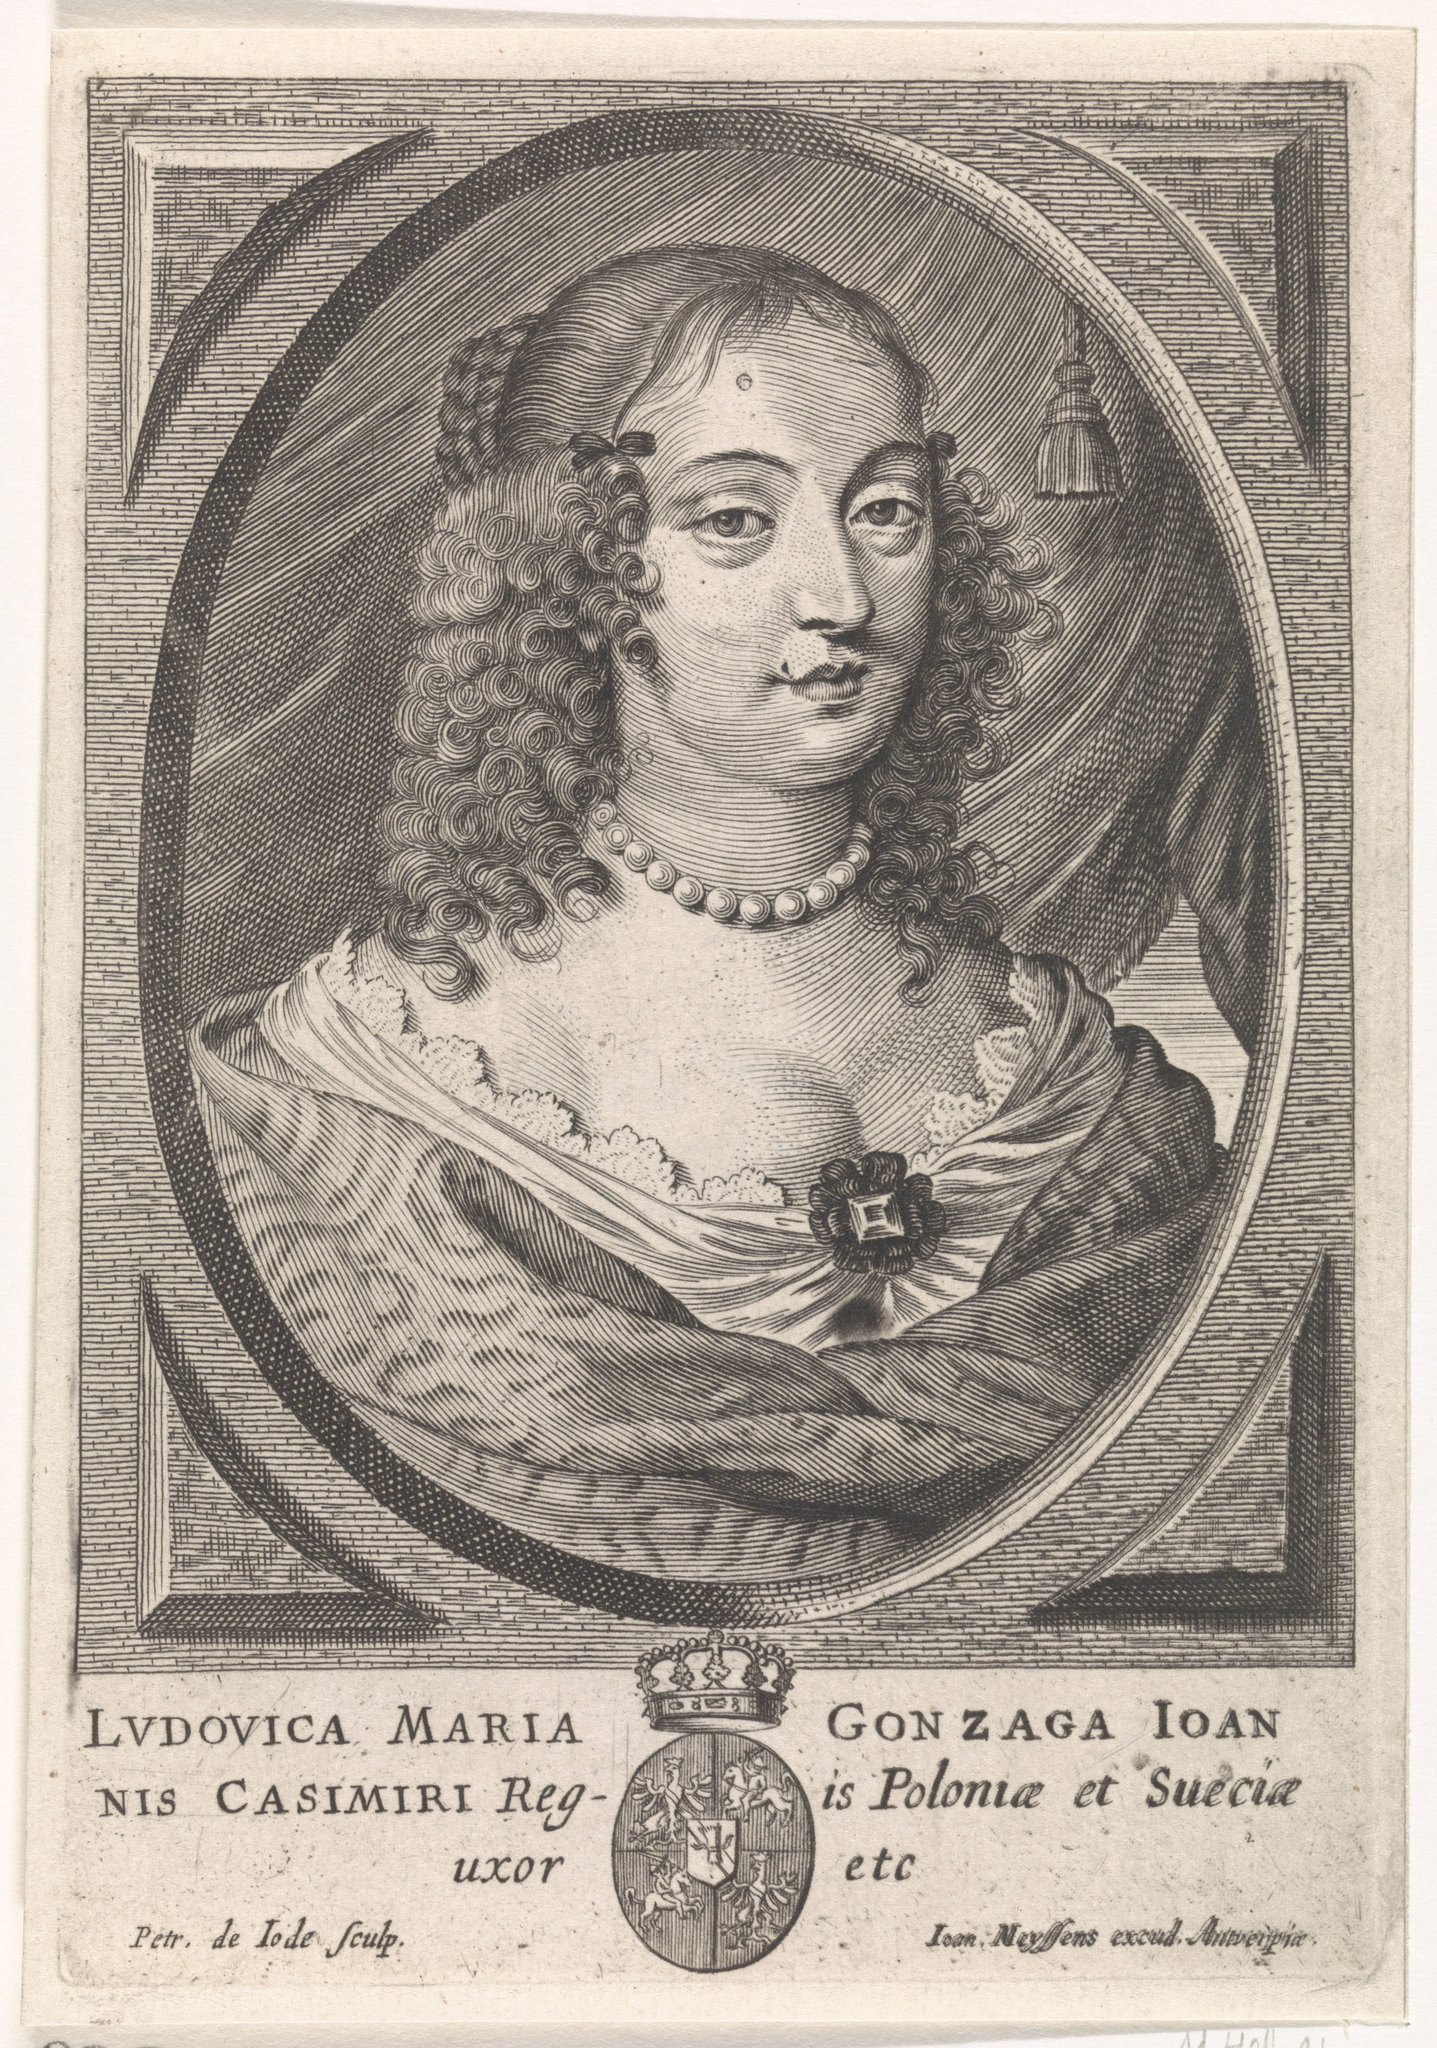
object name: print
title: Portret van Maria Ludovica Gonzaga, koningin van Polen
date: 1628-1670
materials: paper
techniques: engraving, etching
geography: antwerp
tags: koningin, maria ludovica gonzaga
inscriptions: collector's mark: Lugt 2228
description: Busteportret van Ludwika Maria Gonzaga (ook: Maria Ludovica van Gonzaga-Nevers ), gemalin van Januari Kazimierz (Jan II Casimir), koning van Polen. Het portret is gevat in een ovale omlijsting met vierkant randwerk. In de marge het wapenschild van de geportretteerde en een drieregelig onderschrift in het Latijn.